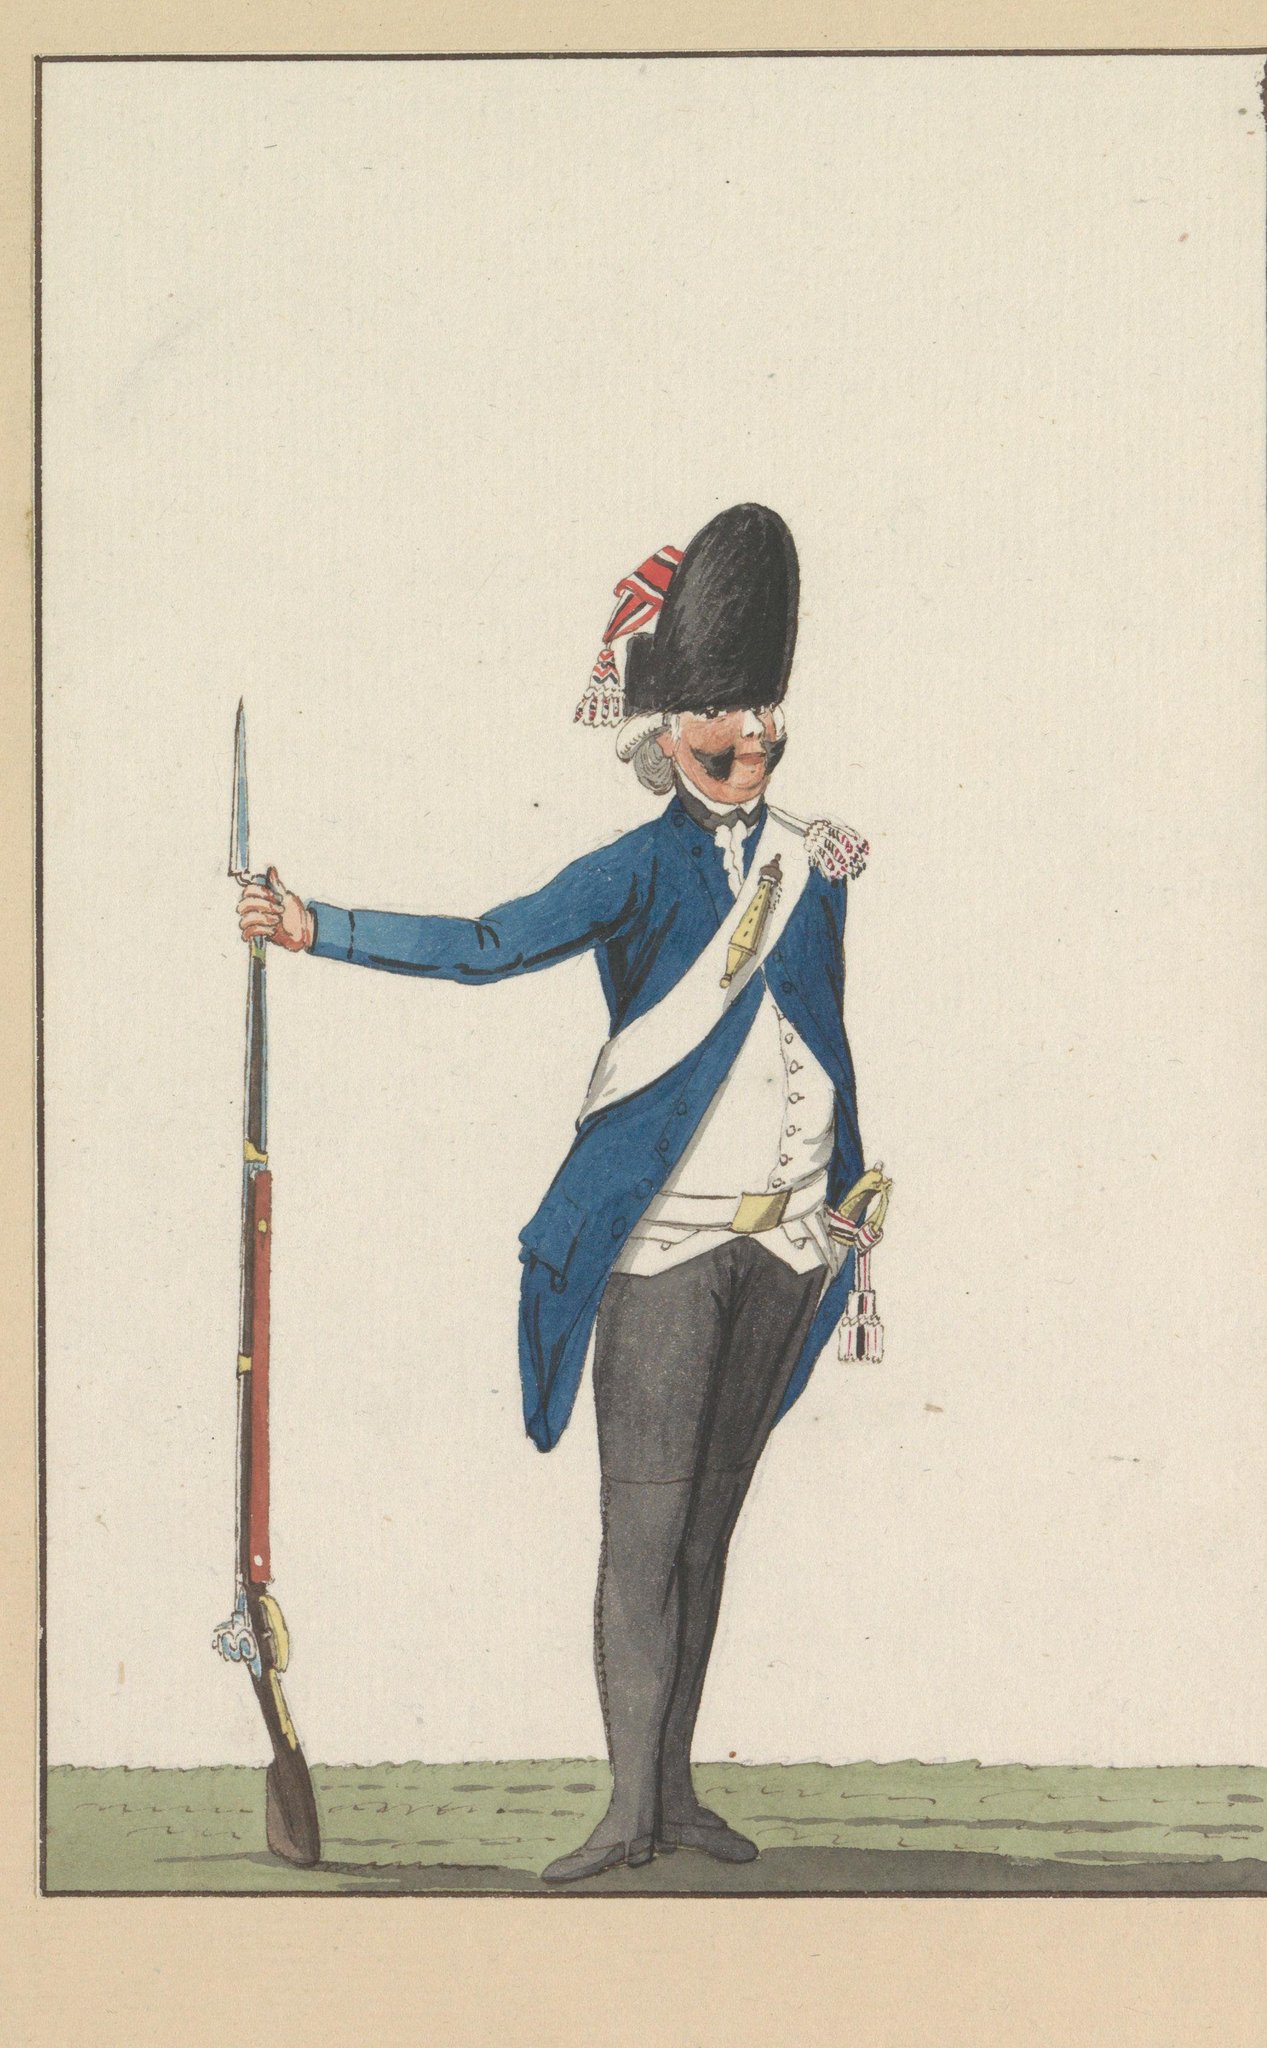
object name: drawing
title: Granadier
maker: Anonymous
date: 1787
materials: paper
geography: amsterdam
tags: (military) uniforms (+ citizen soldiery, civil guard, citizen militia), amsterdam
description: Grenadier, staande met het geweer in de rechterhand rustend op de grond. Onderdeel van het album met veertien ingeplakte gekleurde tekeningen van de uniformen van schutters van het patriotse Genootschap tot Nut der Schutterij te Amsterdam in het jaar 1787.